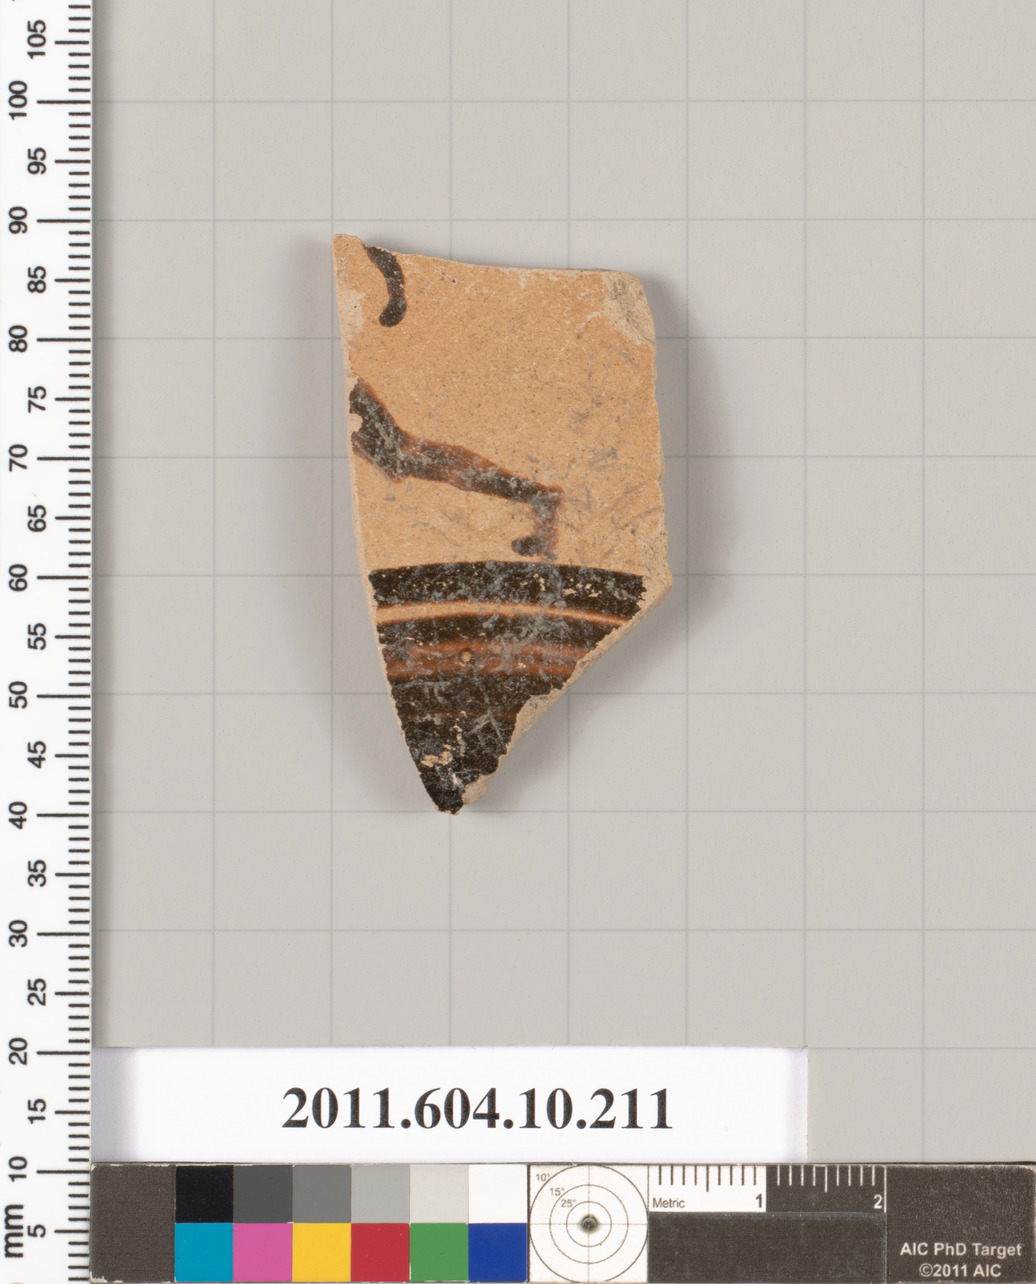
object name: amphora fragment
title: Terracotta fragment of an amphora (jar)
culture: etruscan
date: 600-501 BCE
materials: terracotta